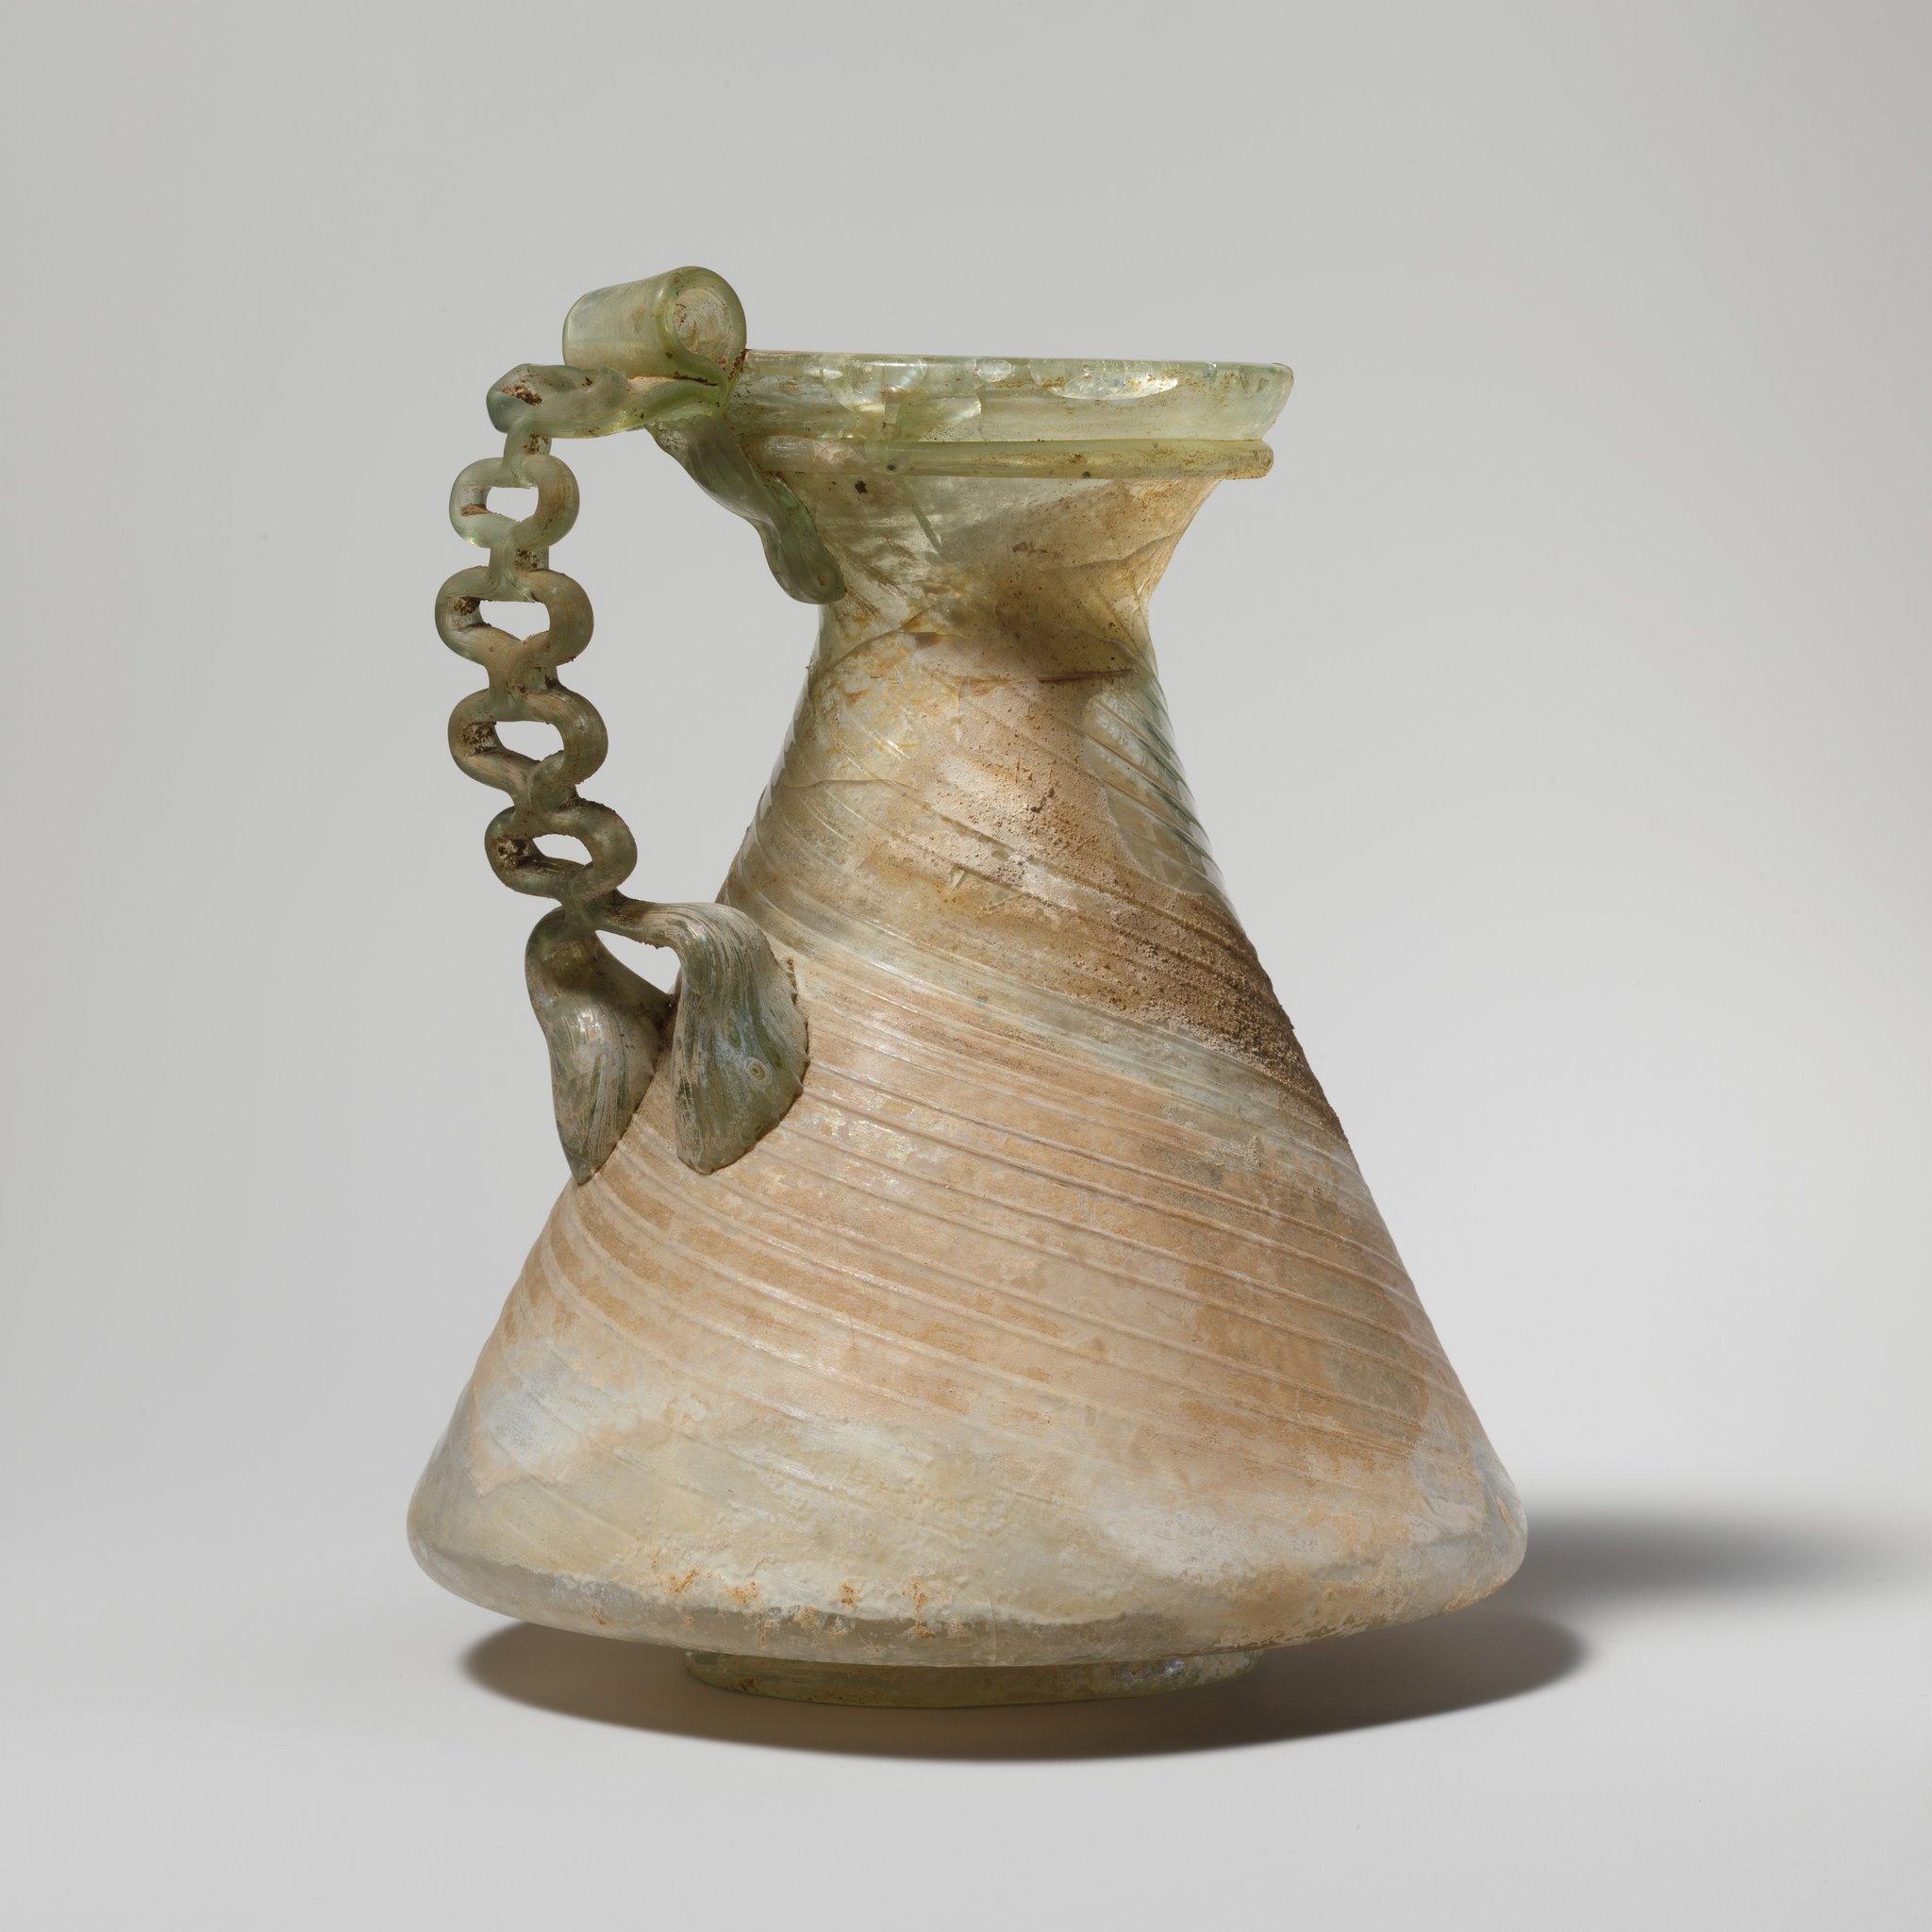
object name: jug with chain handle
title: Glass jug with chain handle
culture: roman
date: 201-300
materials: glass